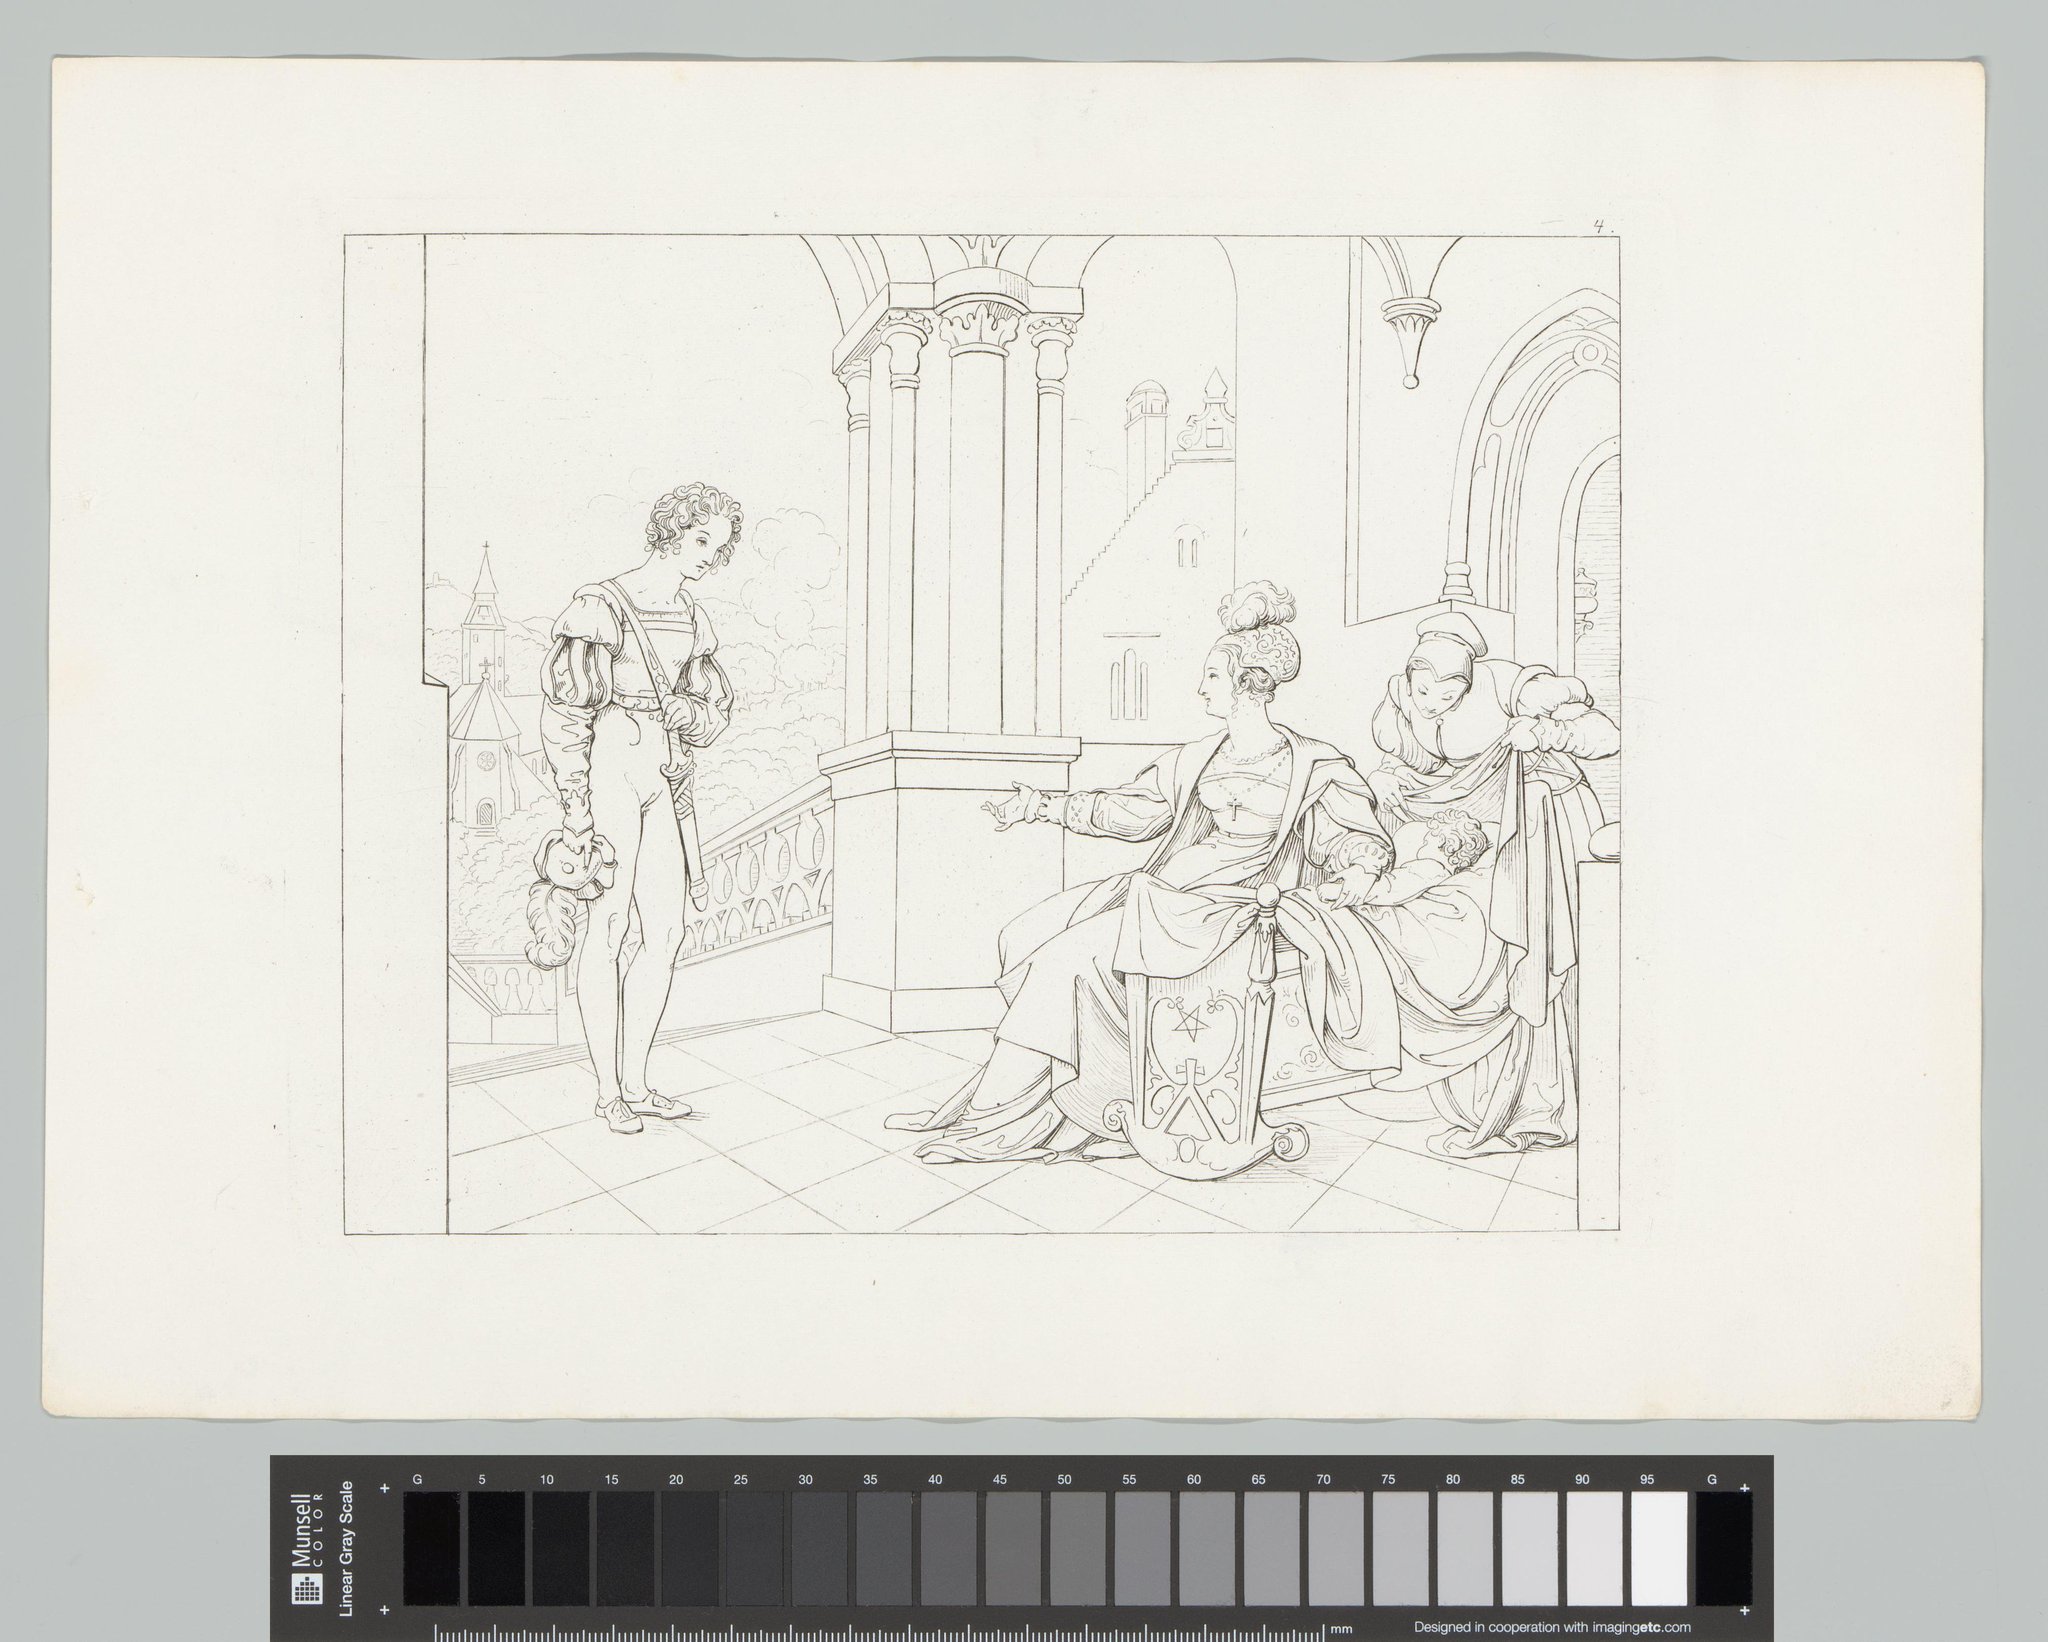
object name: print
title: Schiller's Fridolin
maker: moritz retzsch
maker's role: print maker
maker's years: 1779-1857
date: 1823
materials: paper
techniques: etching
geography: tübingen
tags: visiting the new mother, lying-in visit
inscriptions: date